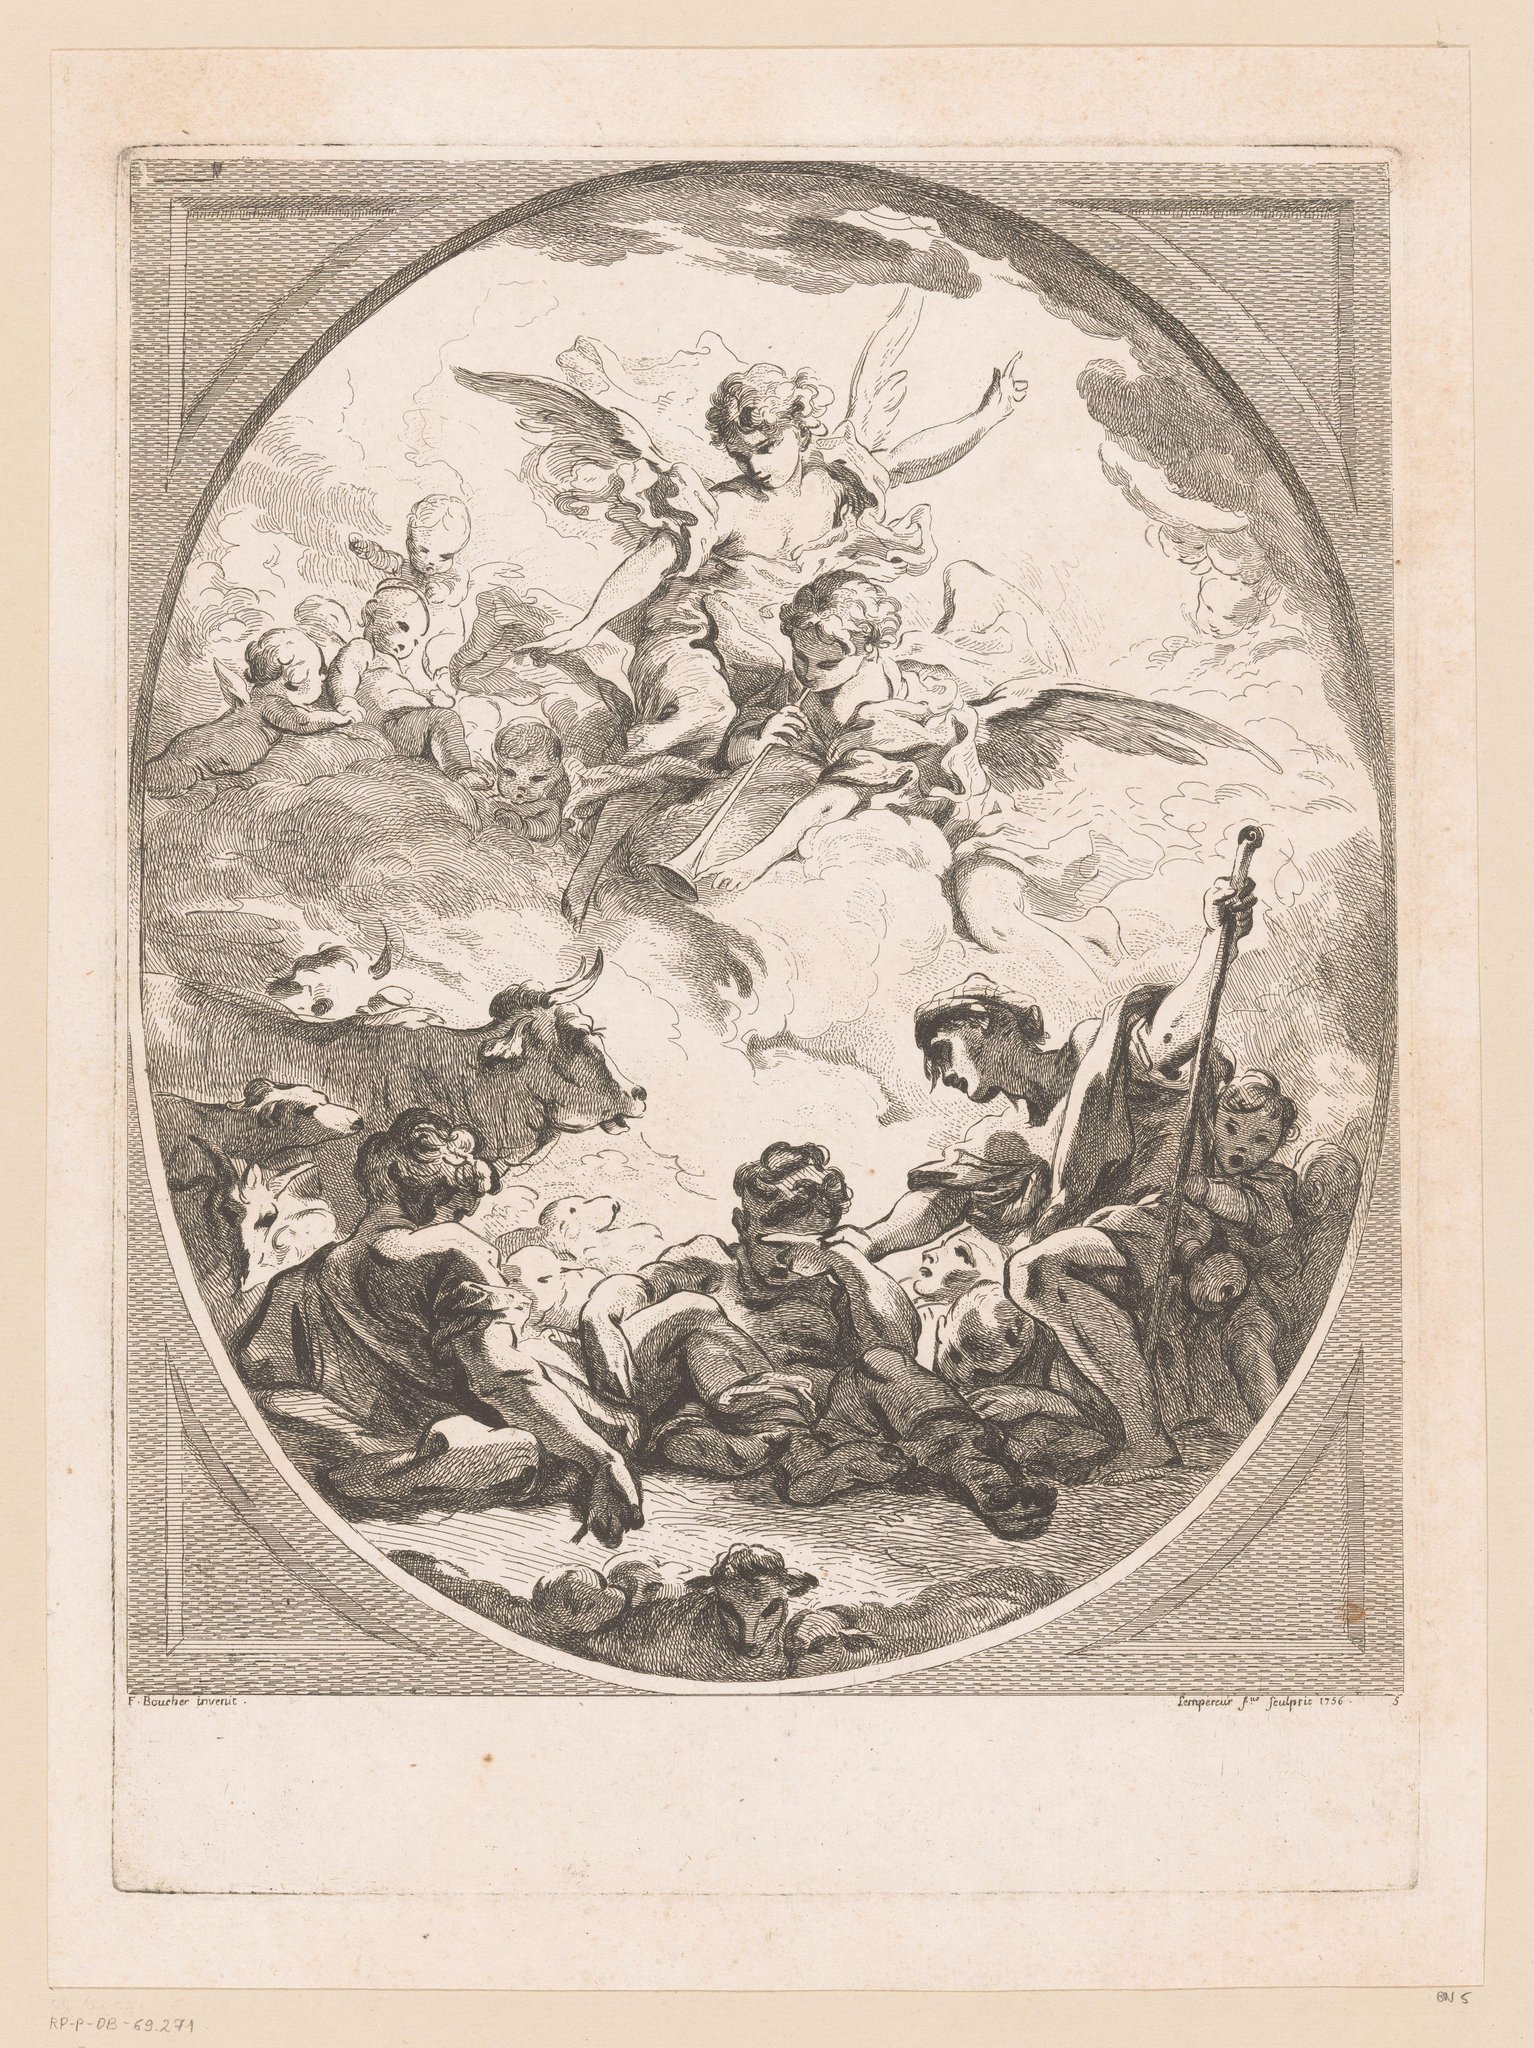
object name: print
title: Verkondiging aan de herders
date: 1756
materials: paper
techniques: etching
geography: france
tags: annunciation of christ's birth to the shepherds (and/or shepherdesses) at night; a host of singing angels in the air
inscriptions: collector's mark: Lugt 240